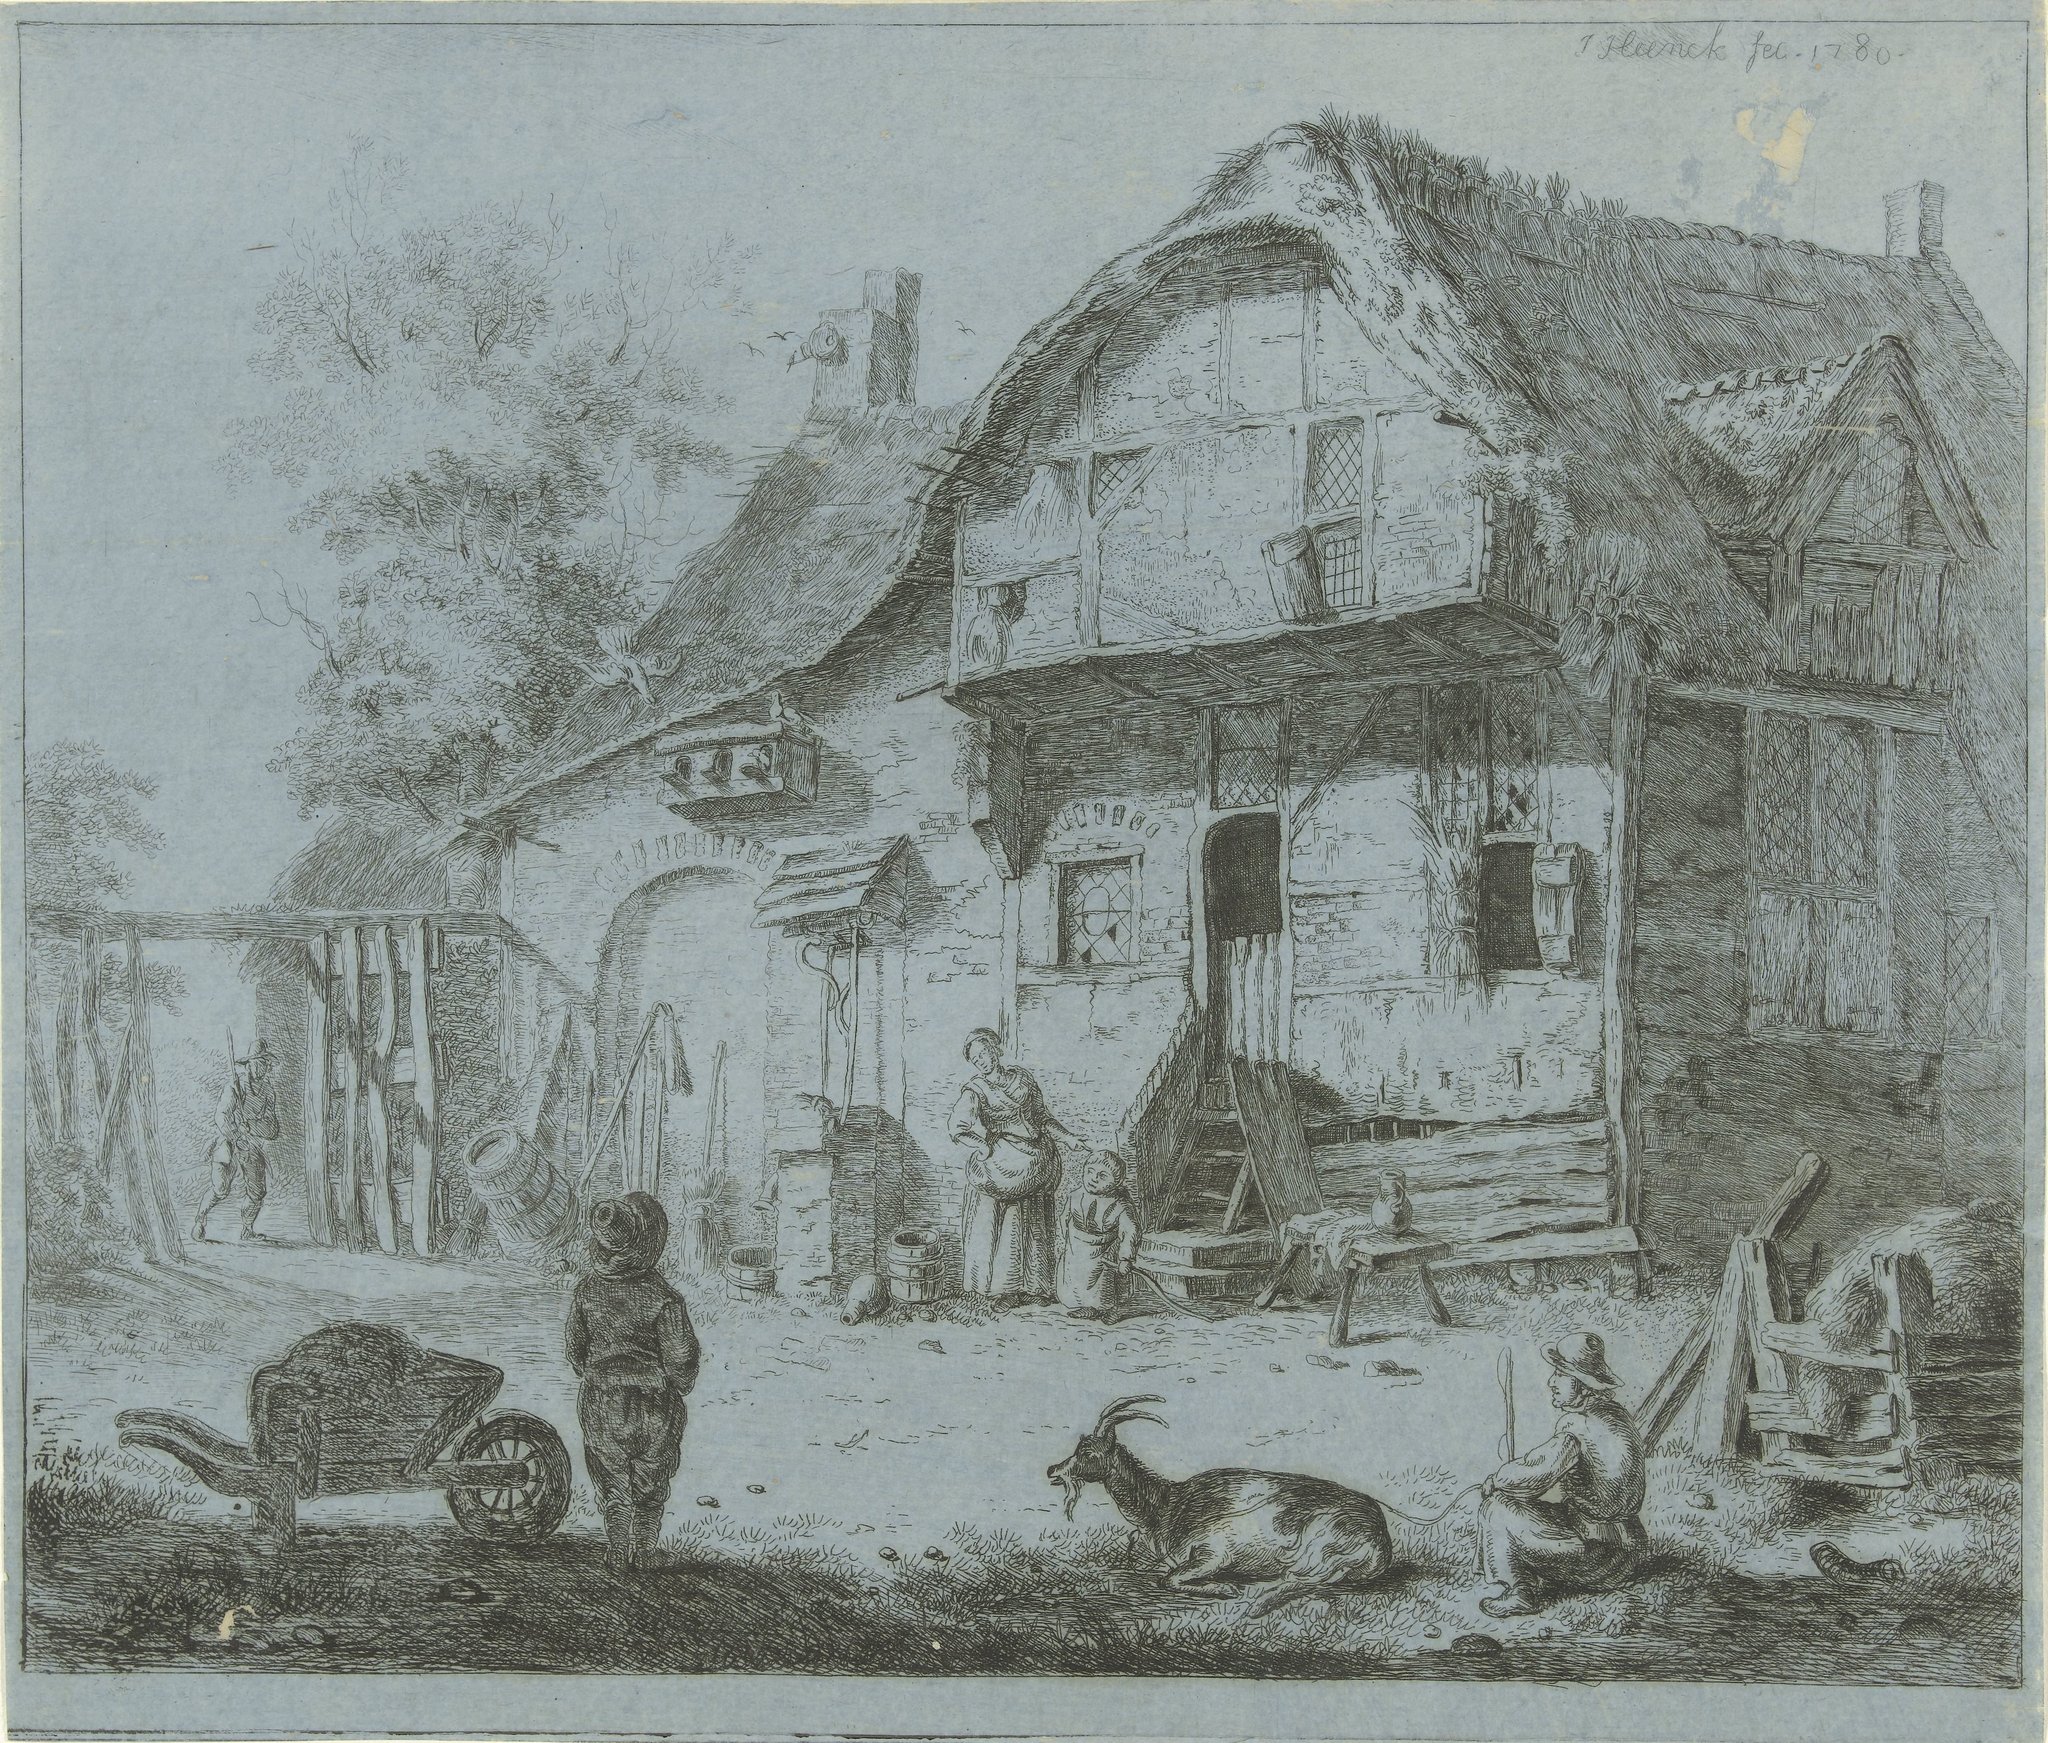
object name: print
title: Figuren bij een boerenhofstede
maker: jabes heenck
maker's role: draughtsman, print maker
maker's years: 1752-1782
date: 1780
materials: paper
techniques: etching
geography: northern netherlands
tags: he-goat, billy-goat, wheelbarrow, farm or solitary house in landscape (+ city(-scape) with figures, staffage)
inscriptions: date